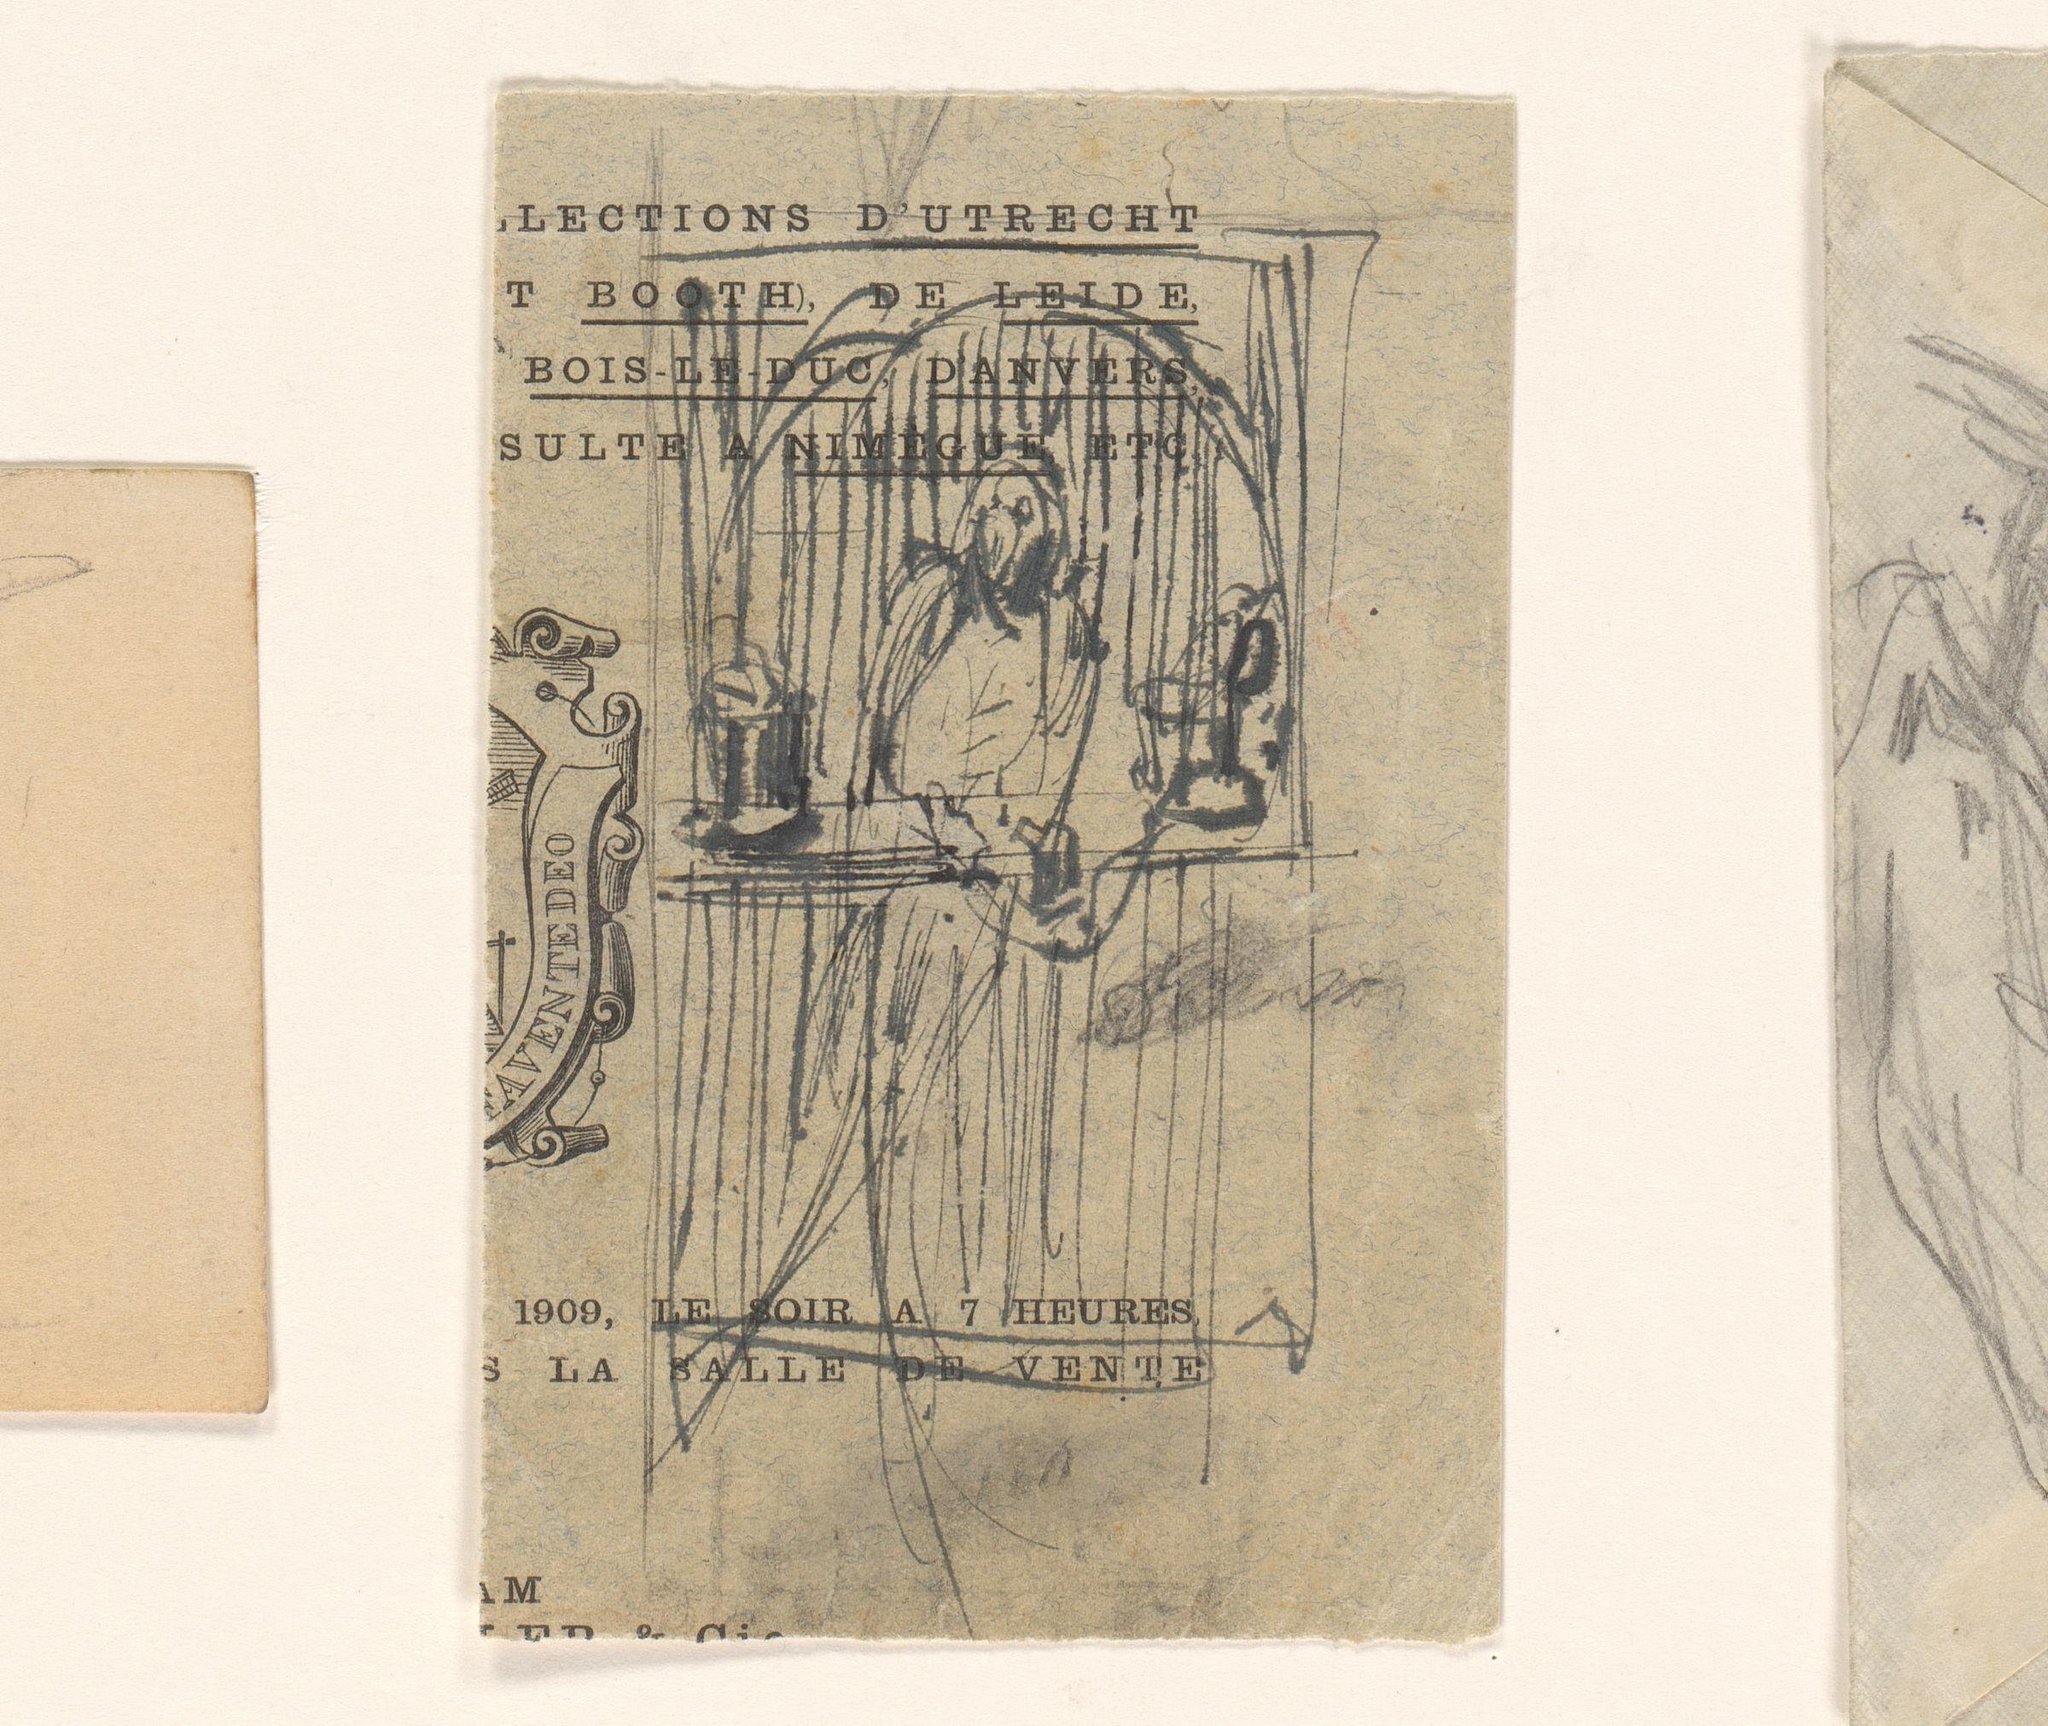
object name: invitation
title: Papegaai in een kooi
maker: august allebé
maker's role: draughtsman, print maker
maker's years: 1838-1927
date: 1848-1927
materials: ink, paper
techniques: pen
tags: ornamental birds: parrot, bird in a cage